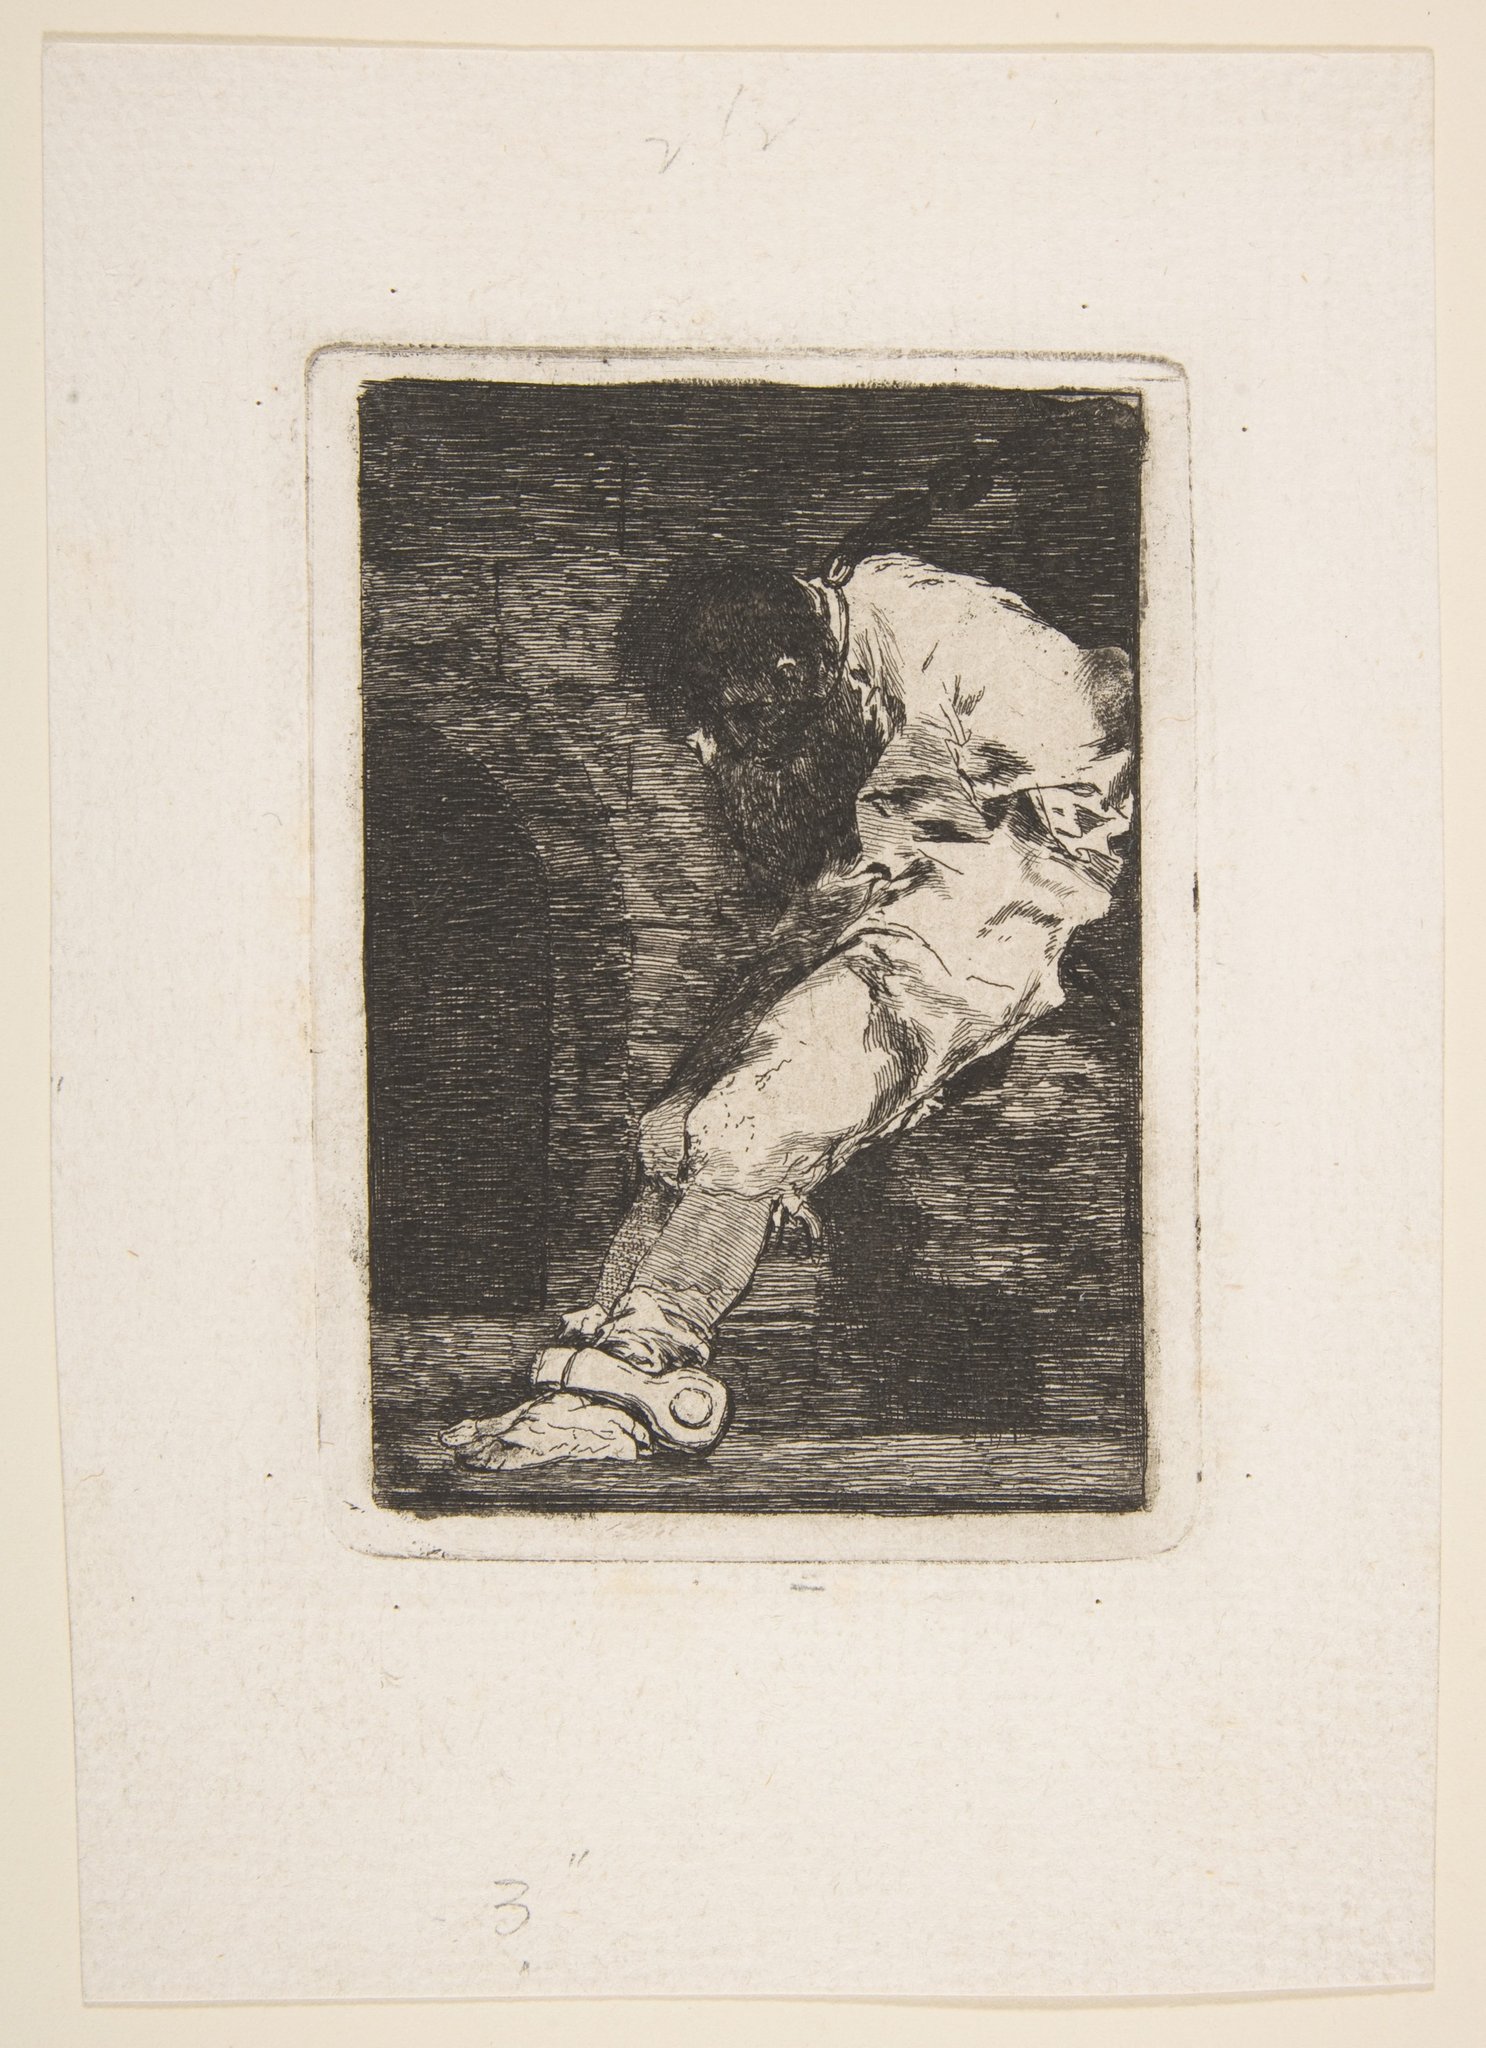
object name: print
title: If he is guilty, let him die quickly (Si es deliquente qe, muera presto)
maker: goya (francisco de goya y lucientes)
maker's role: artist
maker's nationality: spanish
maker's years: 1746-1828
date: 1815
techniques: etching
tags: prisoners,men